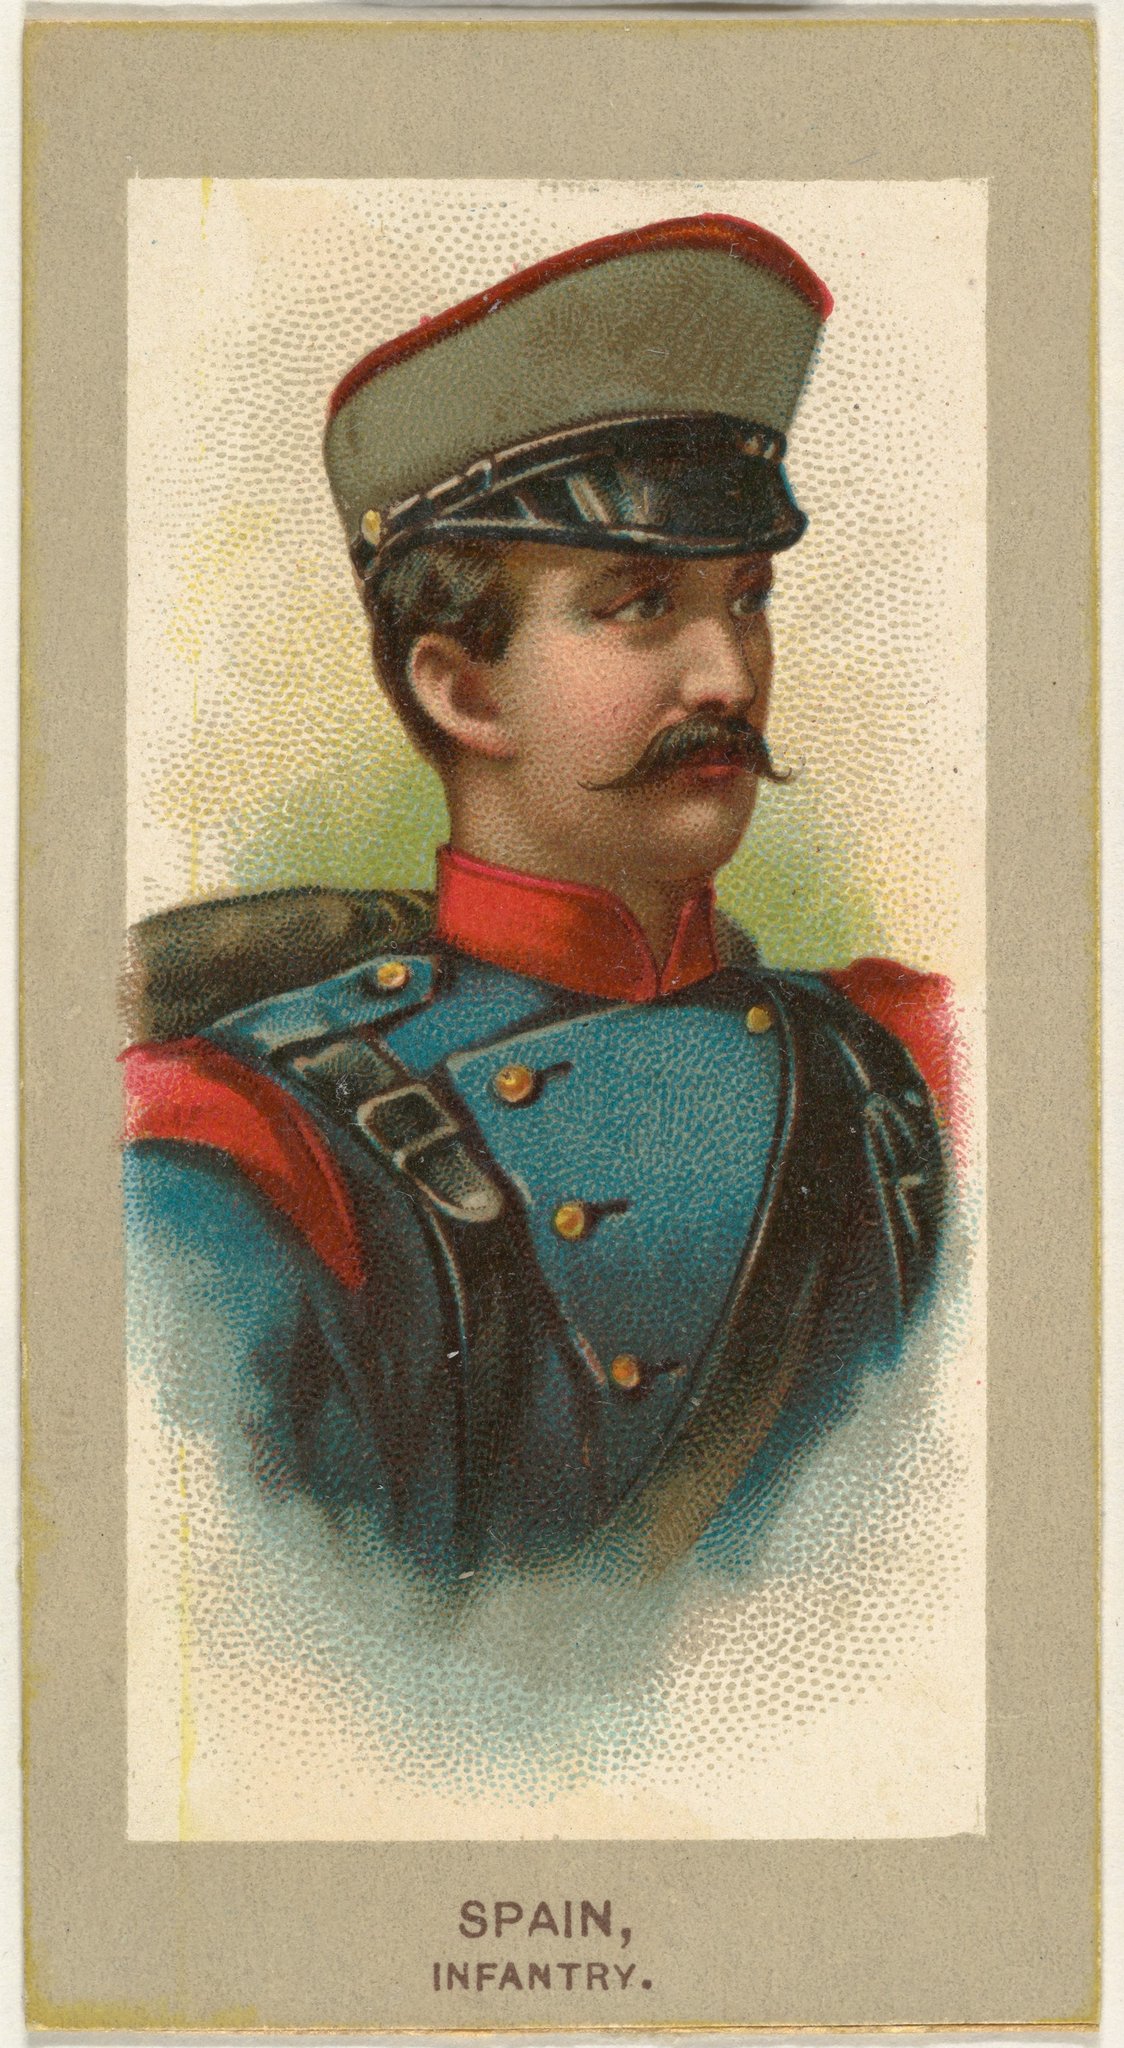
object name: print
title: Infantry, Spain, from the Military Uniforms series (T182) issued by Abdul Cigarettes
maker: abdul cigarettes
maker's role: publisher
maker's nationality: american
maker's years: 1881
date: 1881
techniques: color lithograph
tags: uniforms,military,men